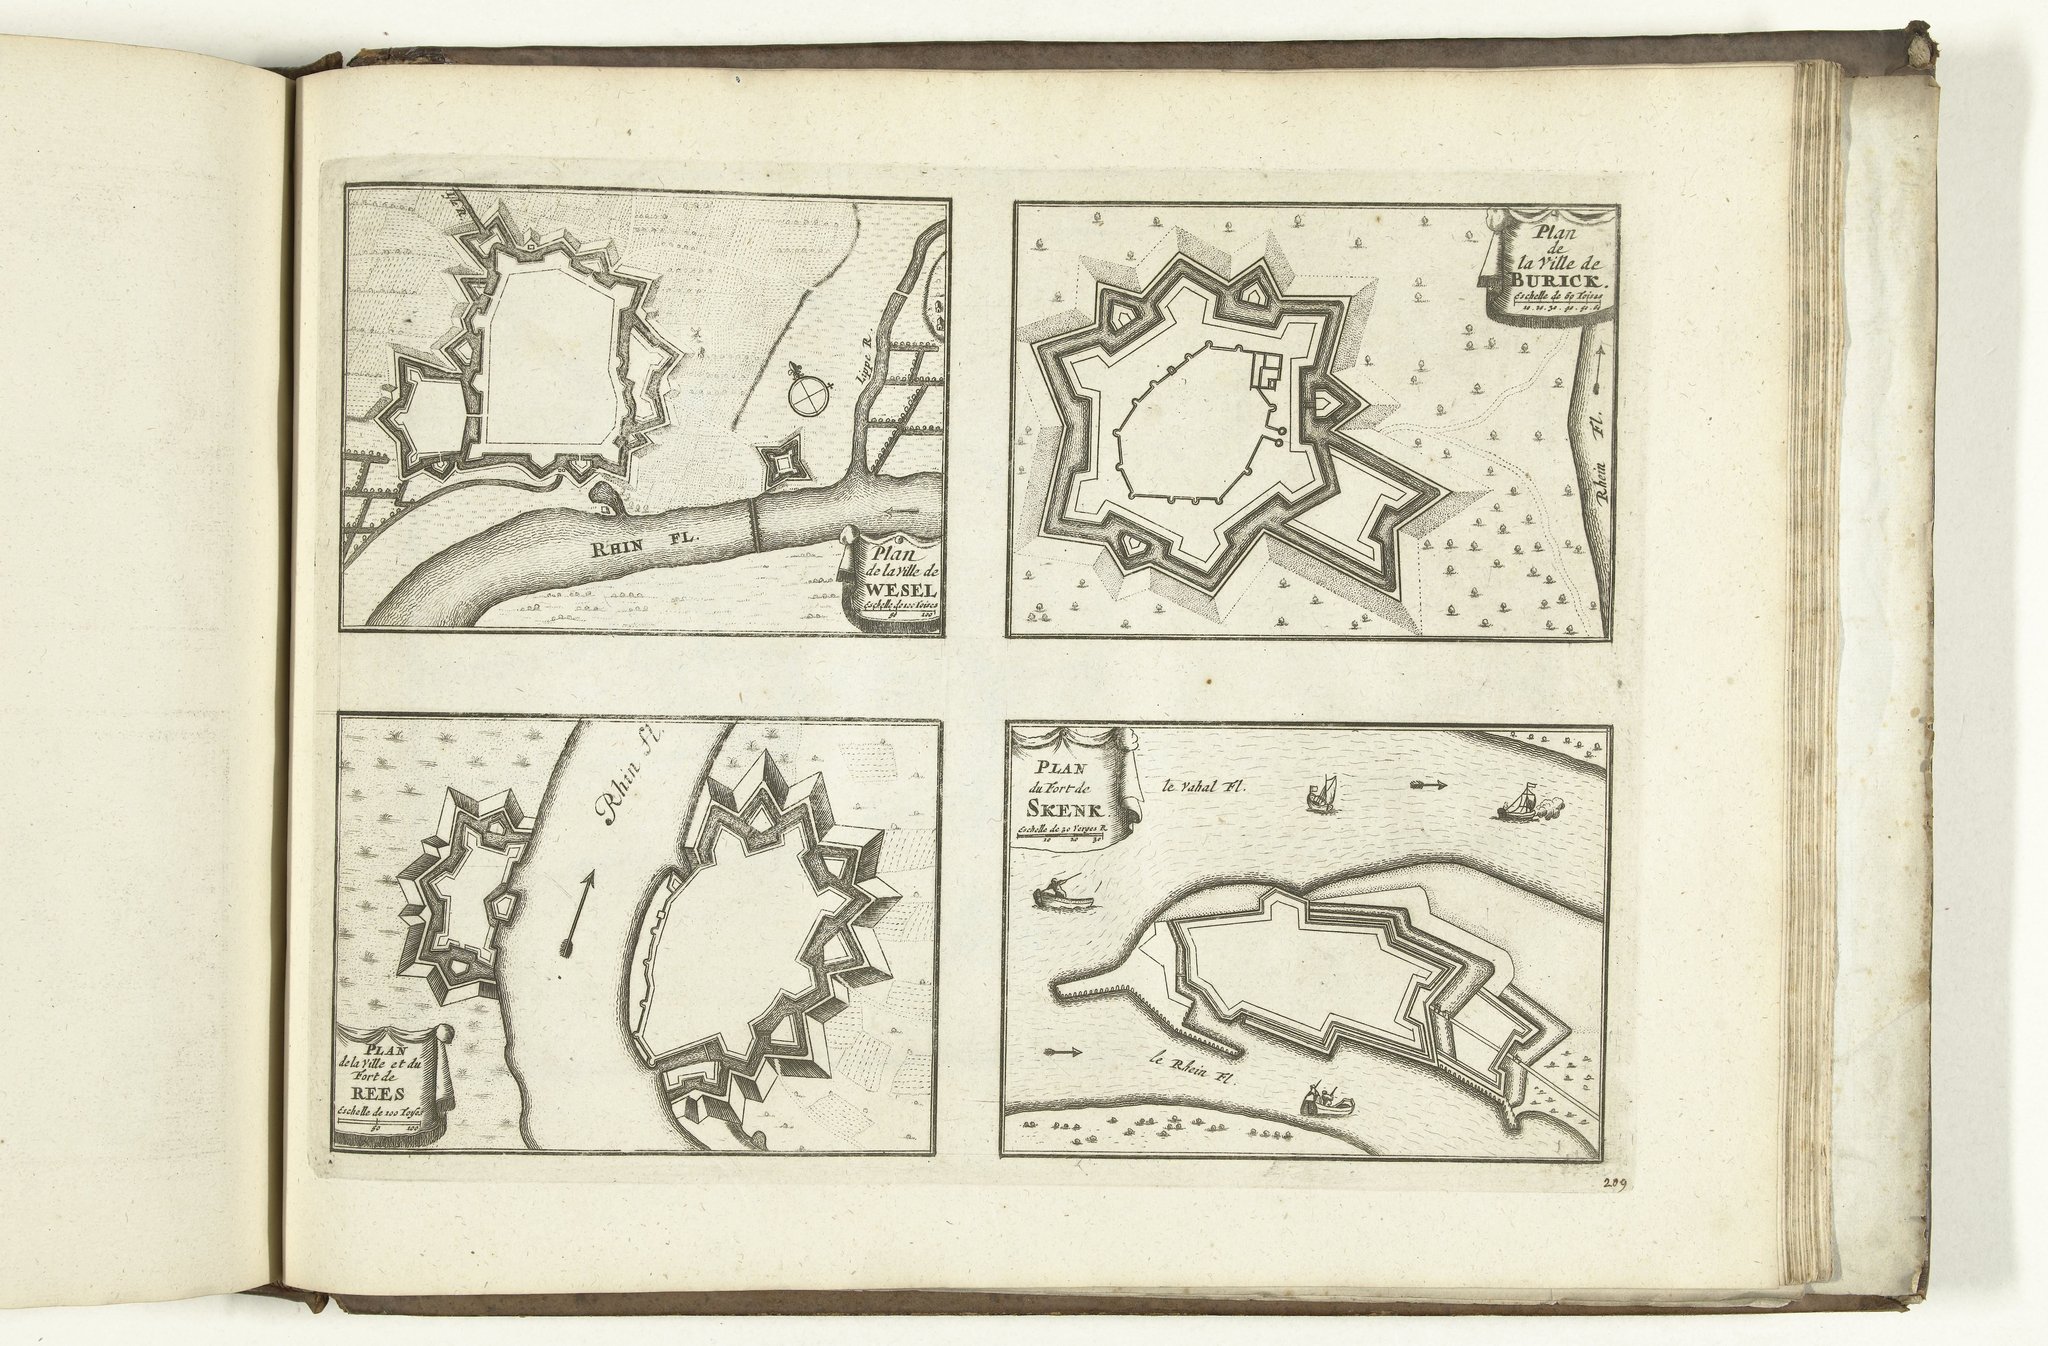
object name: print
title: Les Forces de l'Europe, Asie, Afrique et Amerique (...) Comme aussi les Cartes des Côtes de France et d'Espagne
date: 1726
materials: paper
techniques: etching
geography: leiden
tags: fortress, maps of cities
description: Blad met vier plattegronden van de verdedigingswerken van Wesel, Burick, Rees en Schenckenschans. Plaat nr. 209 in deel IX van het prentwerk: Les Forces de l'Europe, Asie, Afrique et Amerique ... Comme aussi les Cartes des Côtes de France et d'Espagne uit 1726, dit eerste deel met 238 met de hand genummerde platen van vermaarde sterke steden en vestingen in het kader van de Spaanse Successieoorlog 1701-1713. Voor het merendeel zijn deze platen gekopieerd naar de anonieme Franse platen van vermaarde sterke steden en vestingen: in Les forces de l'Europe en in: Le theatre de la guerre, dans les Pays-Bas, beide oorspronkelijk uitgegeven door Nicolas de Fer te Parijs (1693-1697) in het kader van de Negenjarige Oorlog. Titels en opschriften in het Frans.